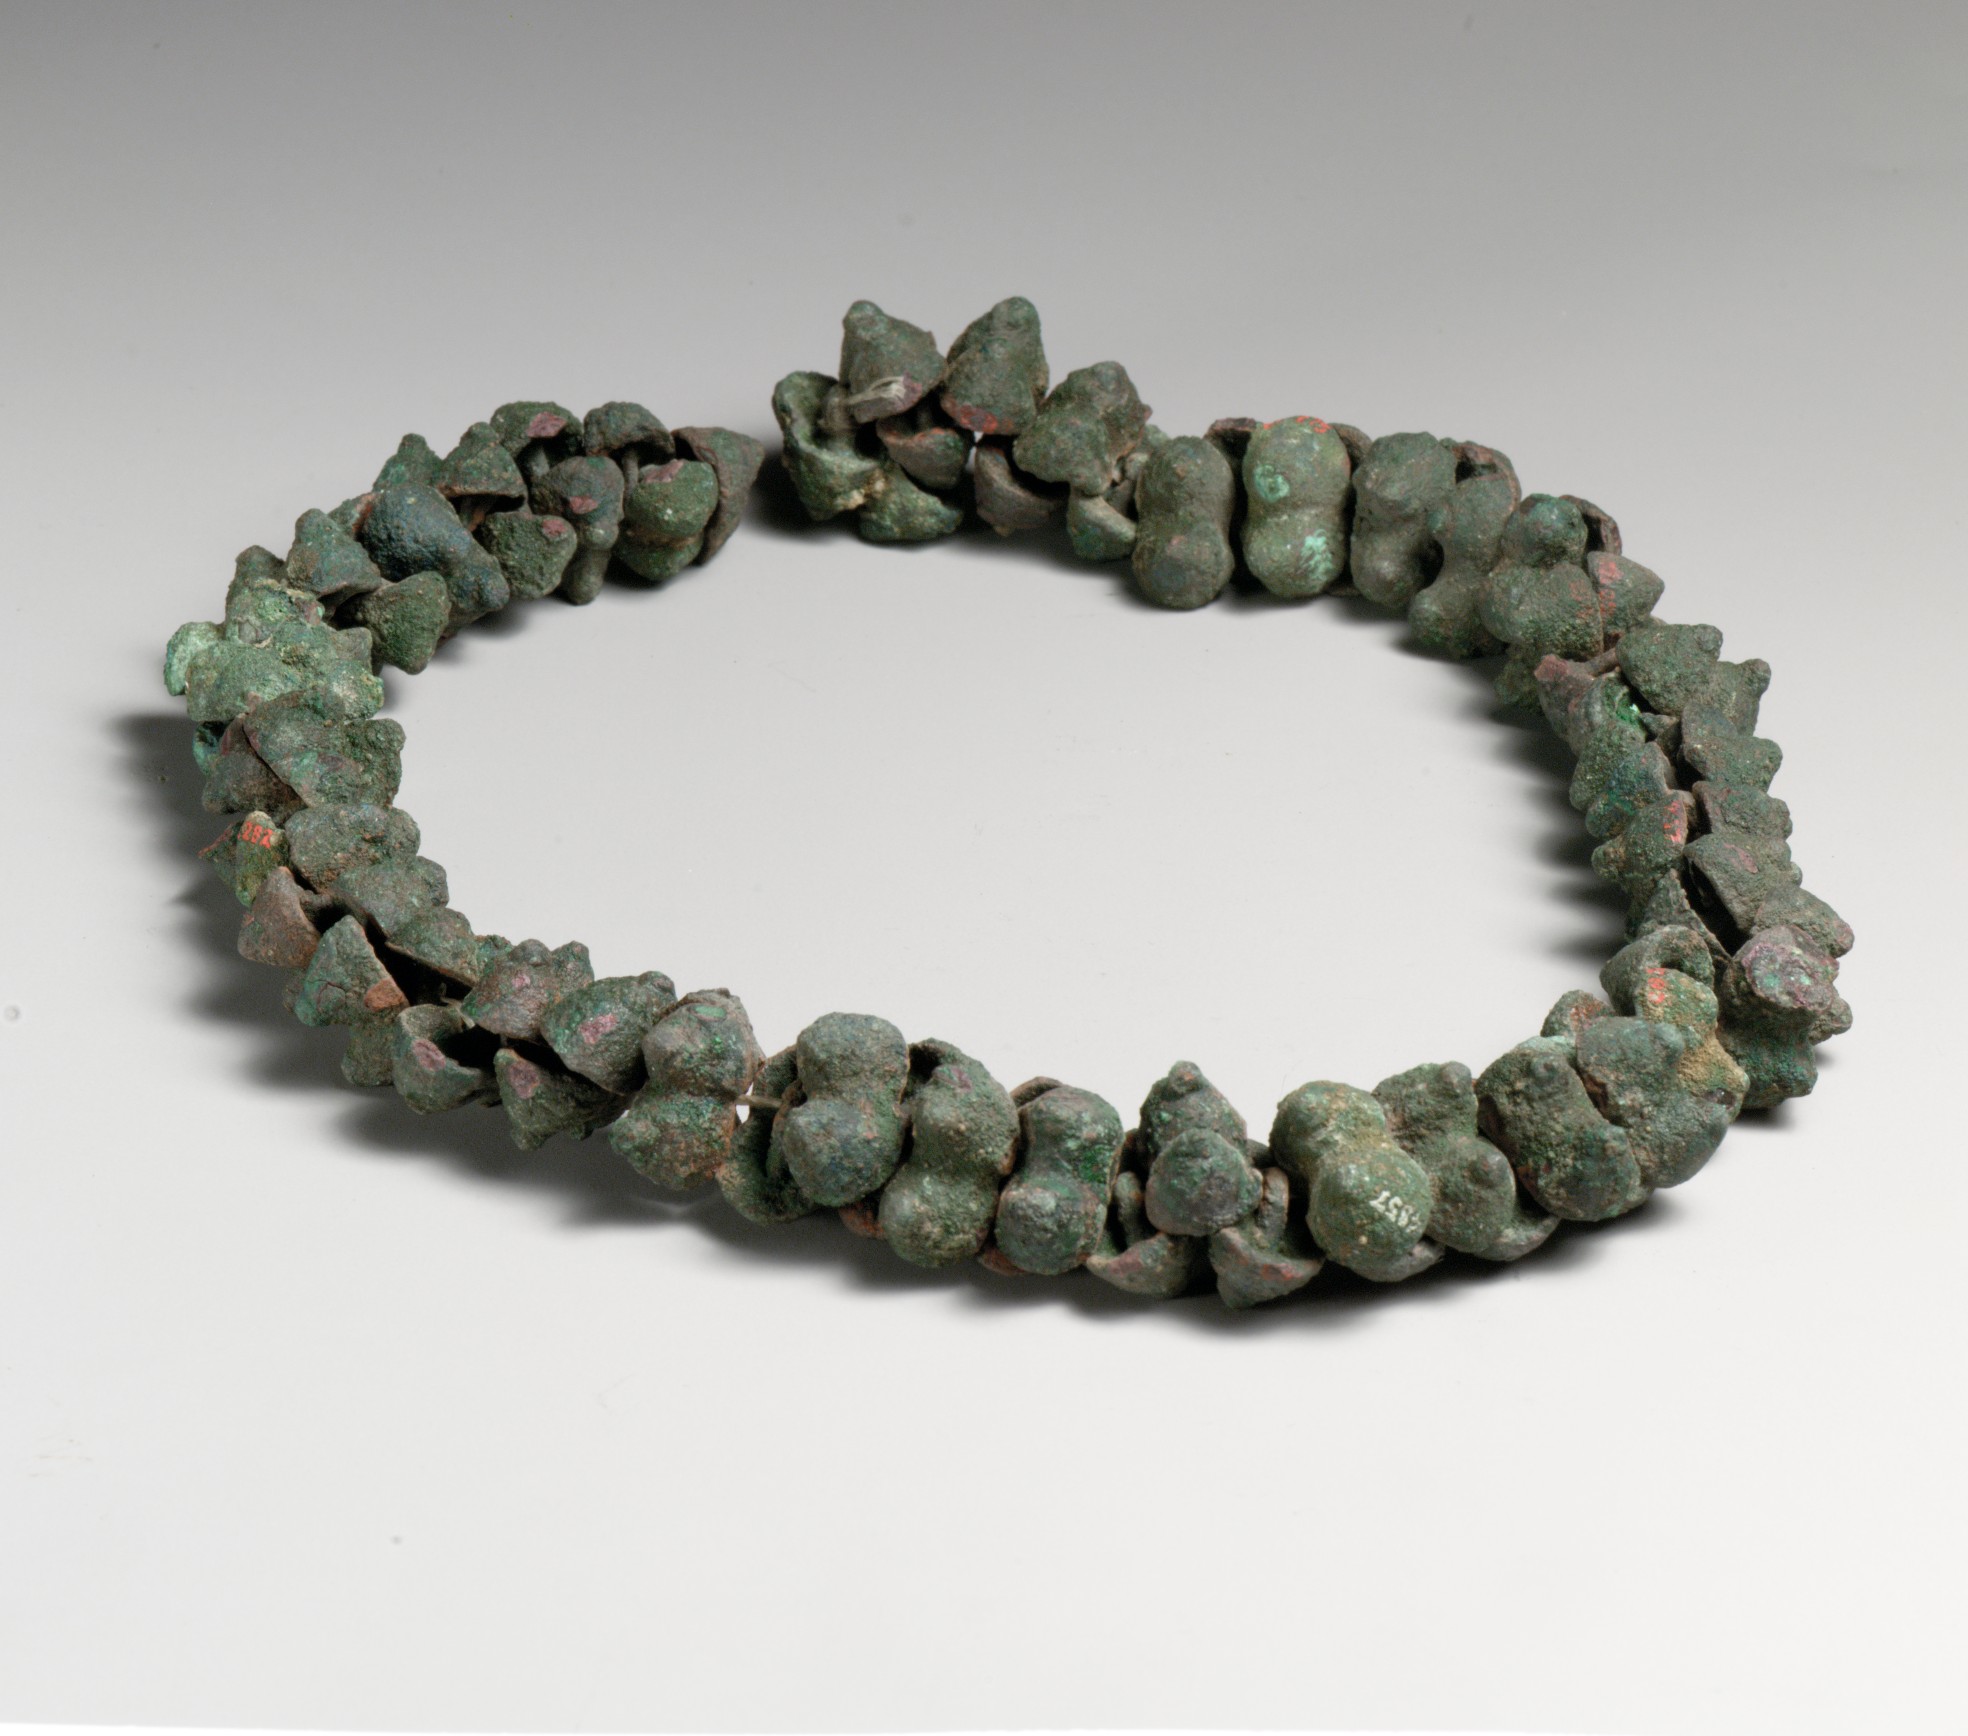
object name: button or bead, 83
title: Bronze buttons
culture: roman, cypriot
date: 1-300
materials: bronze